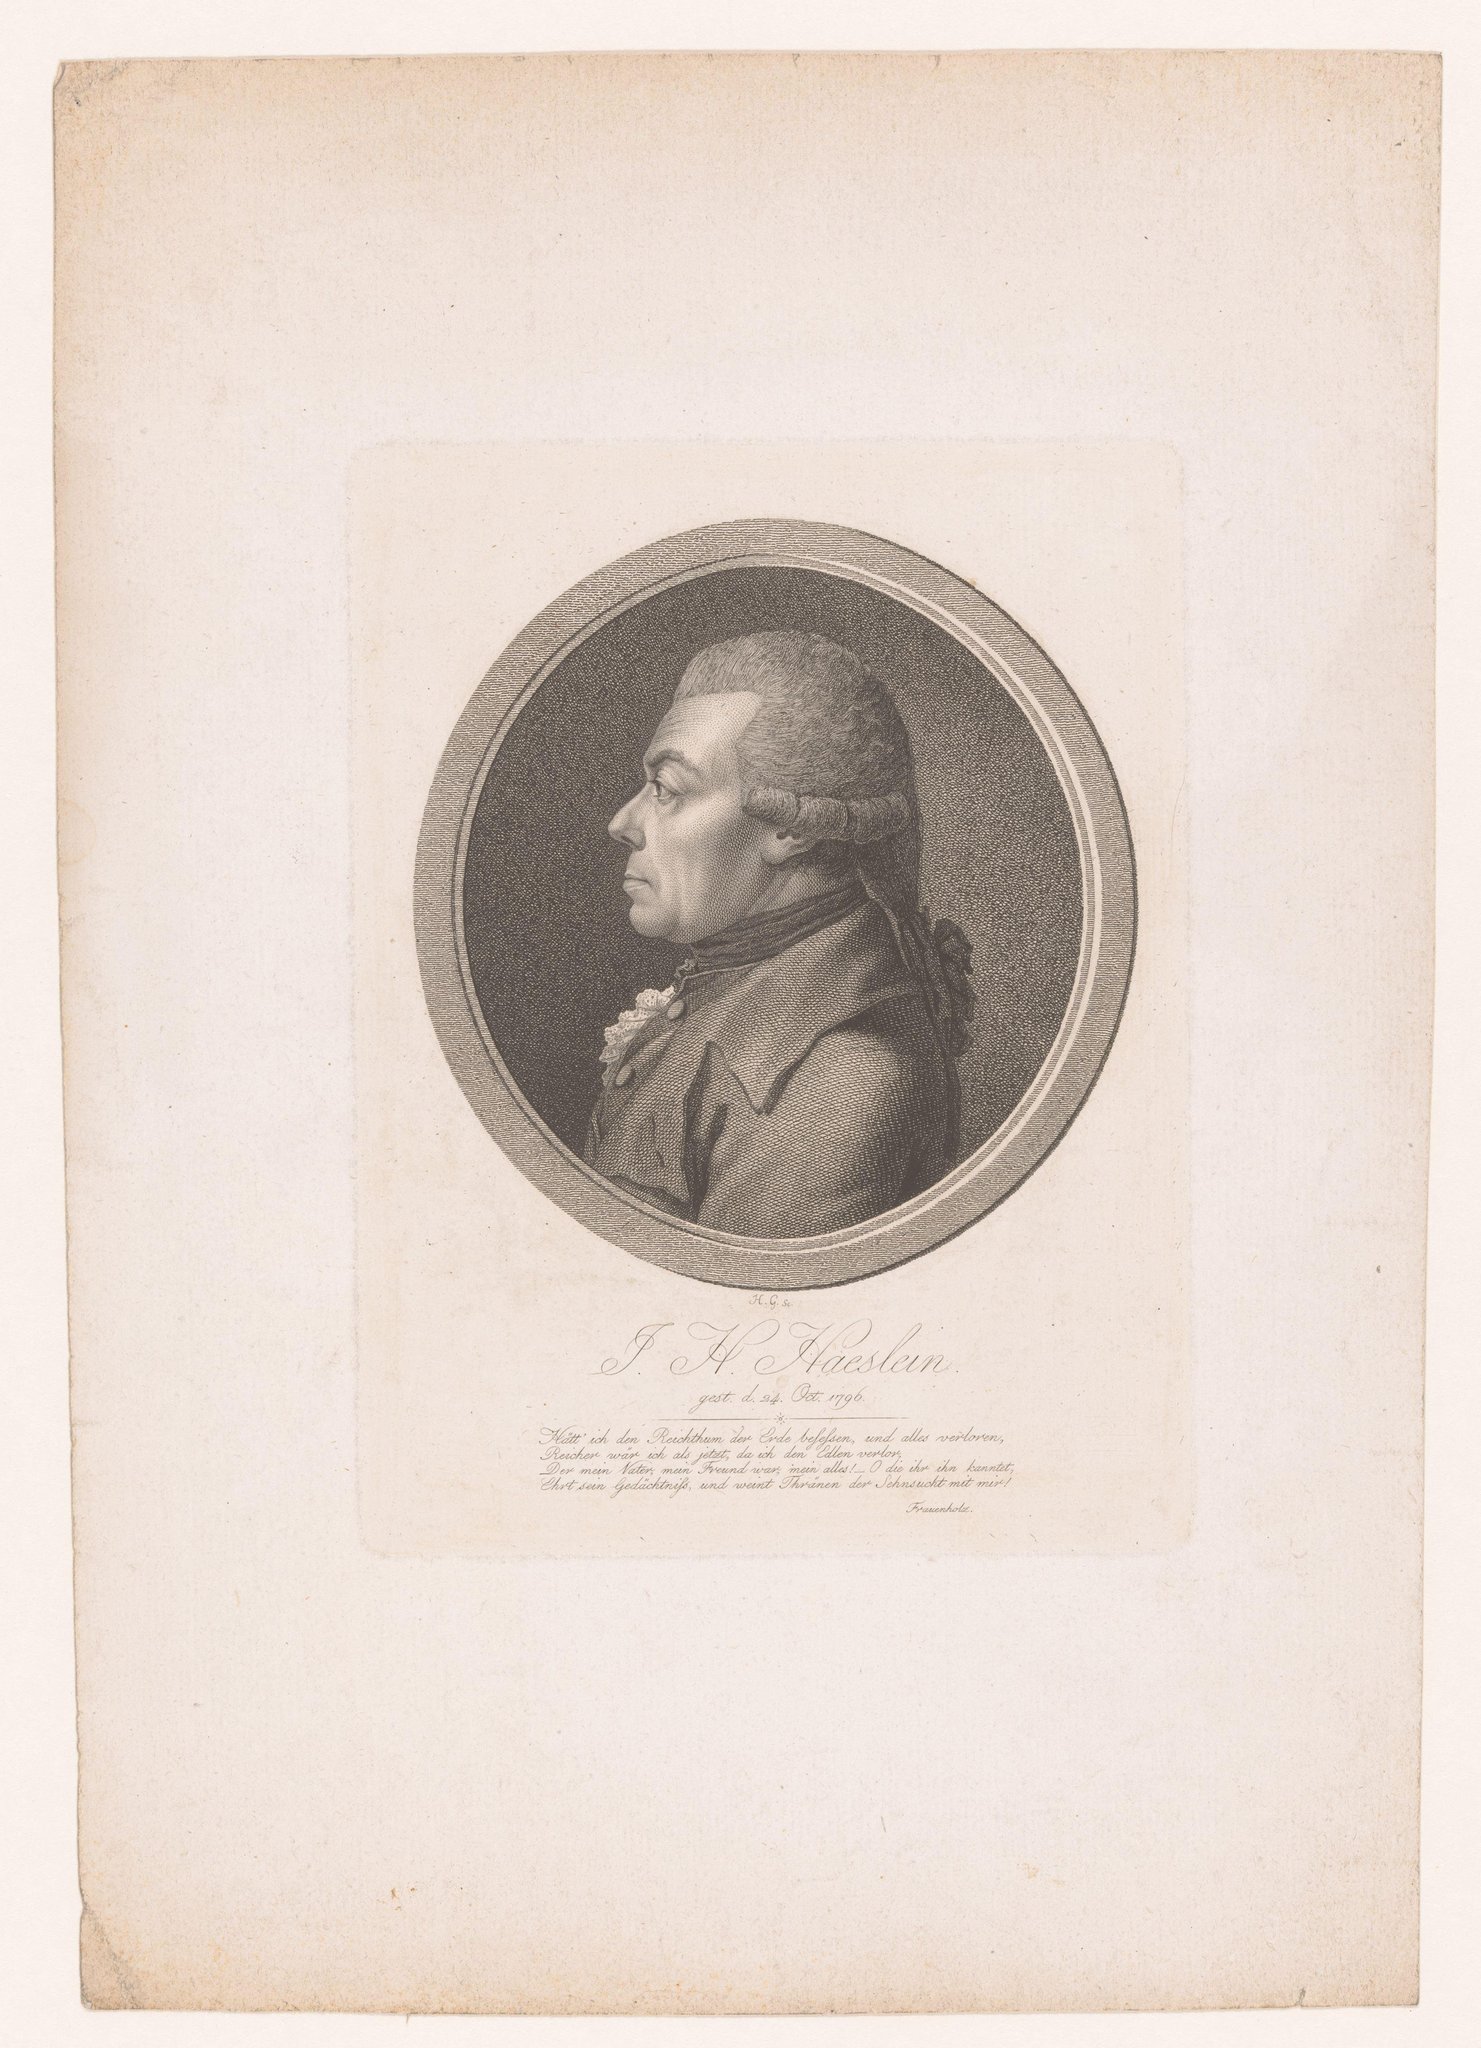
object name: print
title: Portret van Johann Heinrich Hässlein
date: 1796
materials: paper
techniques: etching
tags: historical persons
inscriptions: collector's mark: Lugt 2228